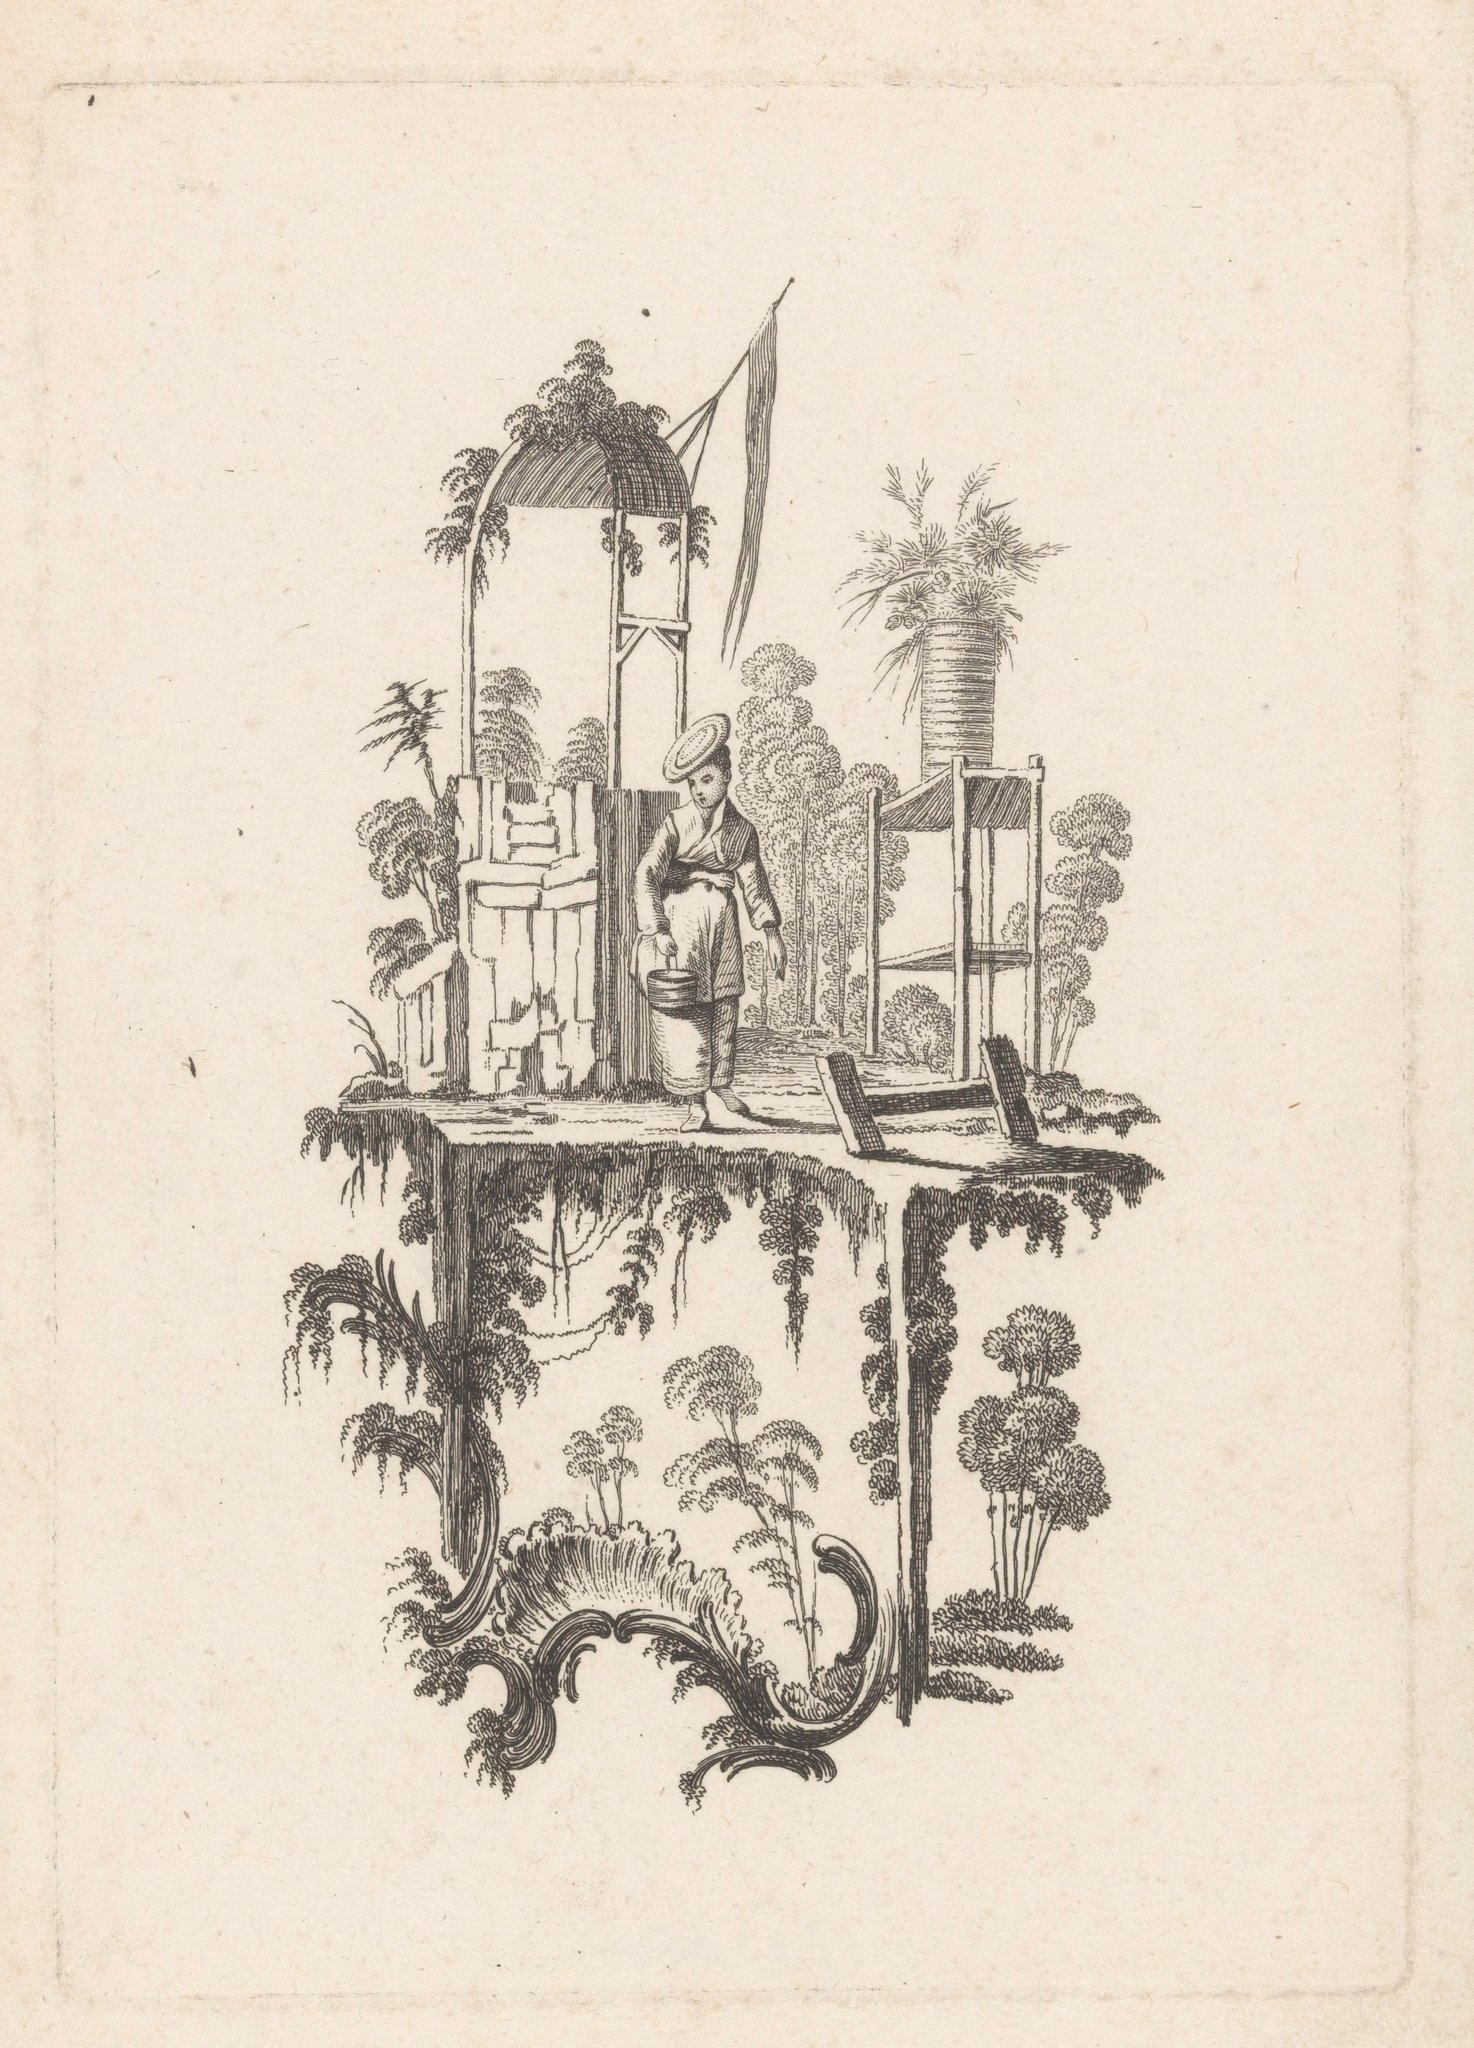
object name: print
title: Petits Ornements Chinois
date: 1755-1775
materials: paper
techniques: etching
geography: paris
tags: wooden container: barrel, cask, bucket, walking - aa - female human figure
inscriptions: collector's mark: Lugt 2228, collector's mark: Lugt 2760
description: In een landschap loopt een vrouw met een emmer en een plat hoofddeksel. Rechts op een rek staat een vaas. Aan de onderzijde rocaille elementen.